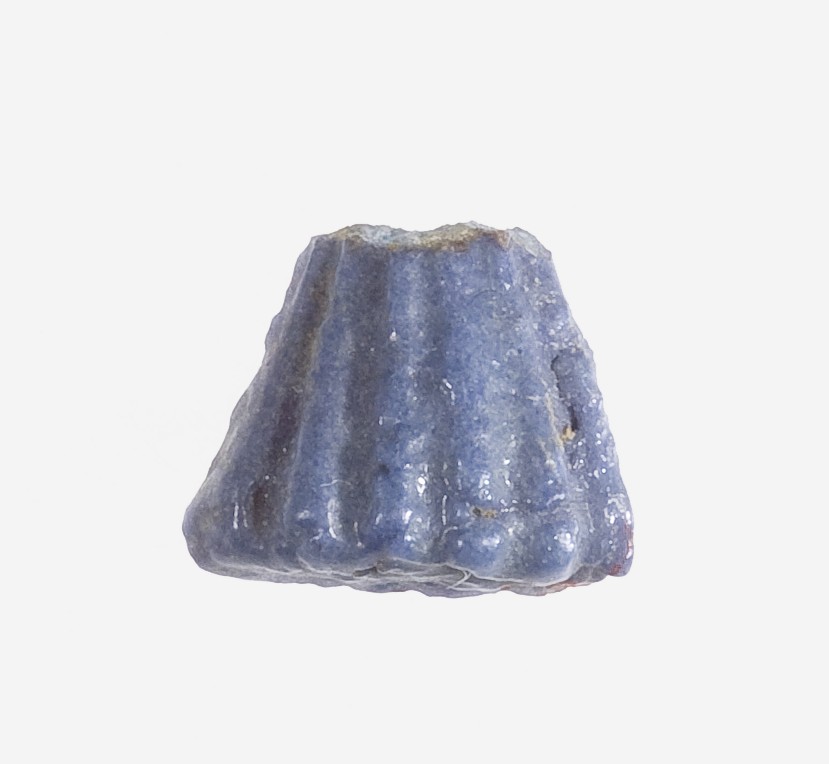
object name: pendant, cornflower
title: Fragments of Cornflower Pendant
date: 1390-1352 BCE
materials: faience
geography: egypt